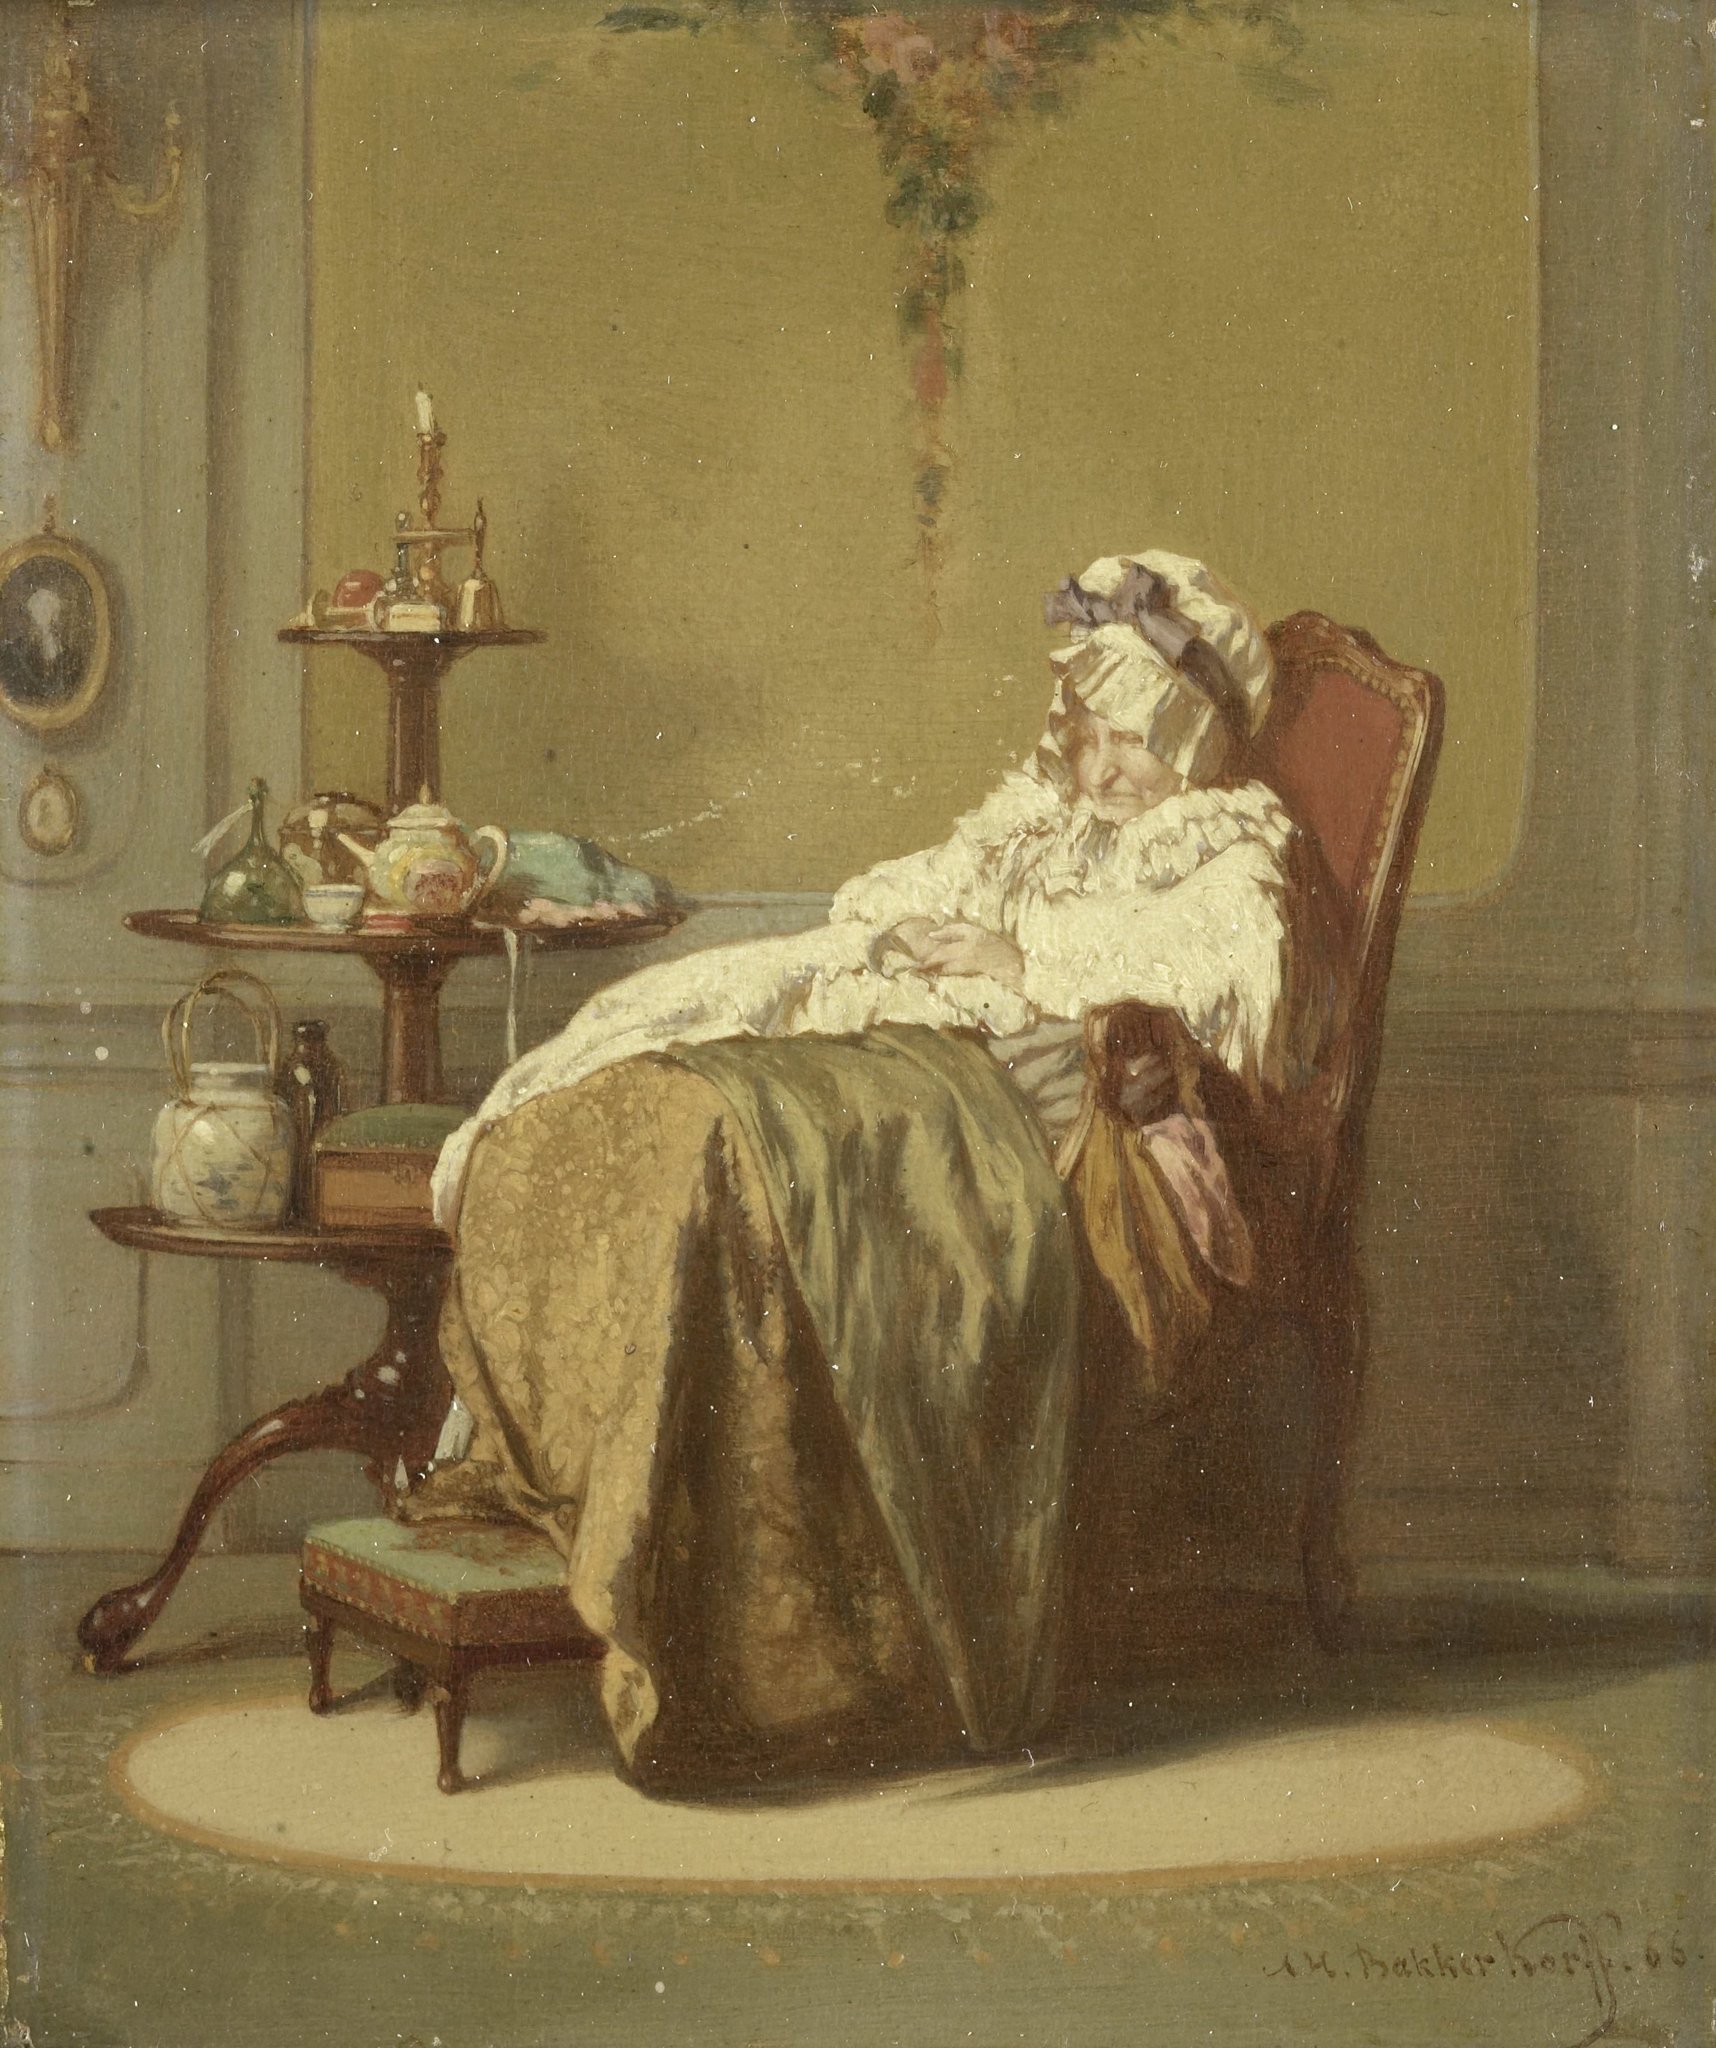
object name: painting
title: Taking a Nap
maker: alexander hugo bakker korff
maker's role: draughtsman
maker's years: 1824-1882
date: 1866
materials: oil, panel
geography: netherlands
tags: sleeping in chair, old woman, communal rooms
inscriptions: signature and date: ‘A.H. Bakker Korff 66’, inscription: ‘Le soussigné déclare que [le] tableau représentant 'Une Siestre' est peint par lui. Leyde le 6 Oct. 1867. AH Bakker Korff’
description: Het middagdutje. Een oude vrouw slaapt, zittend in een leunstoel naast een étagère-tafel.